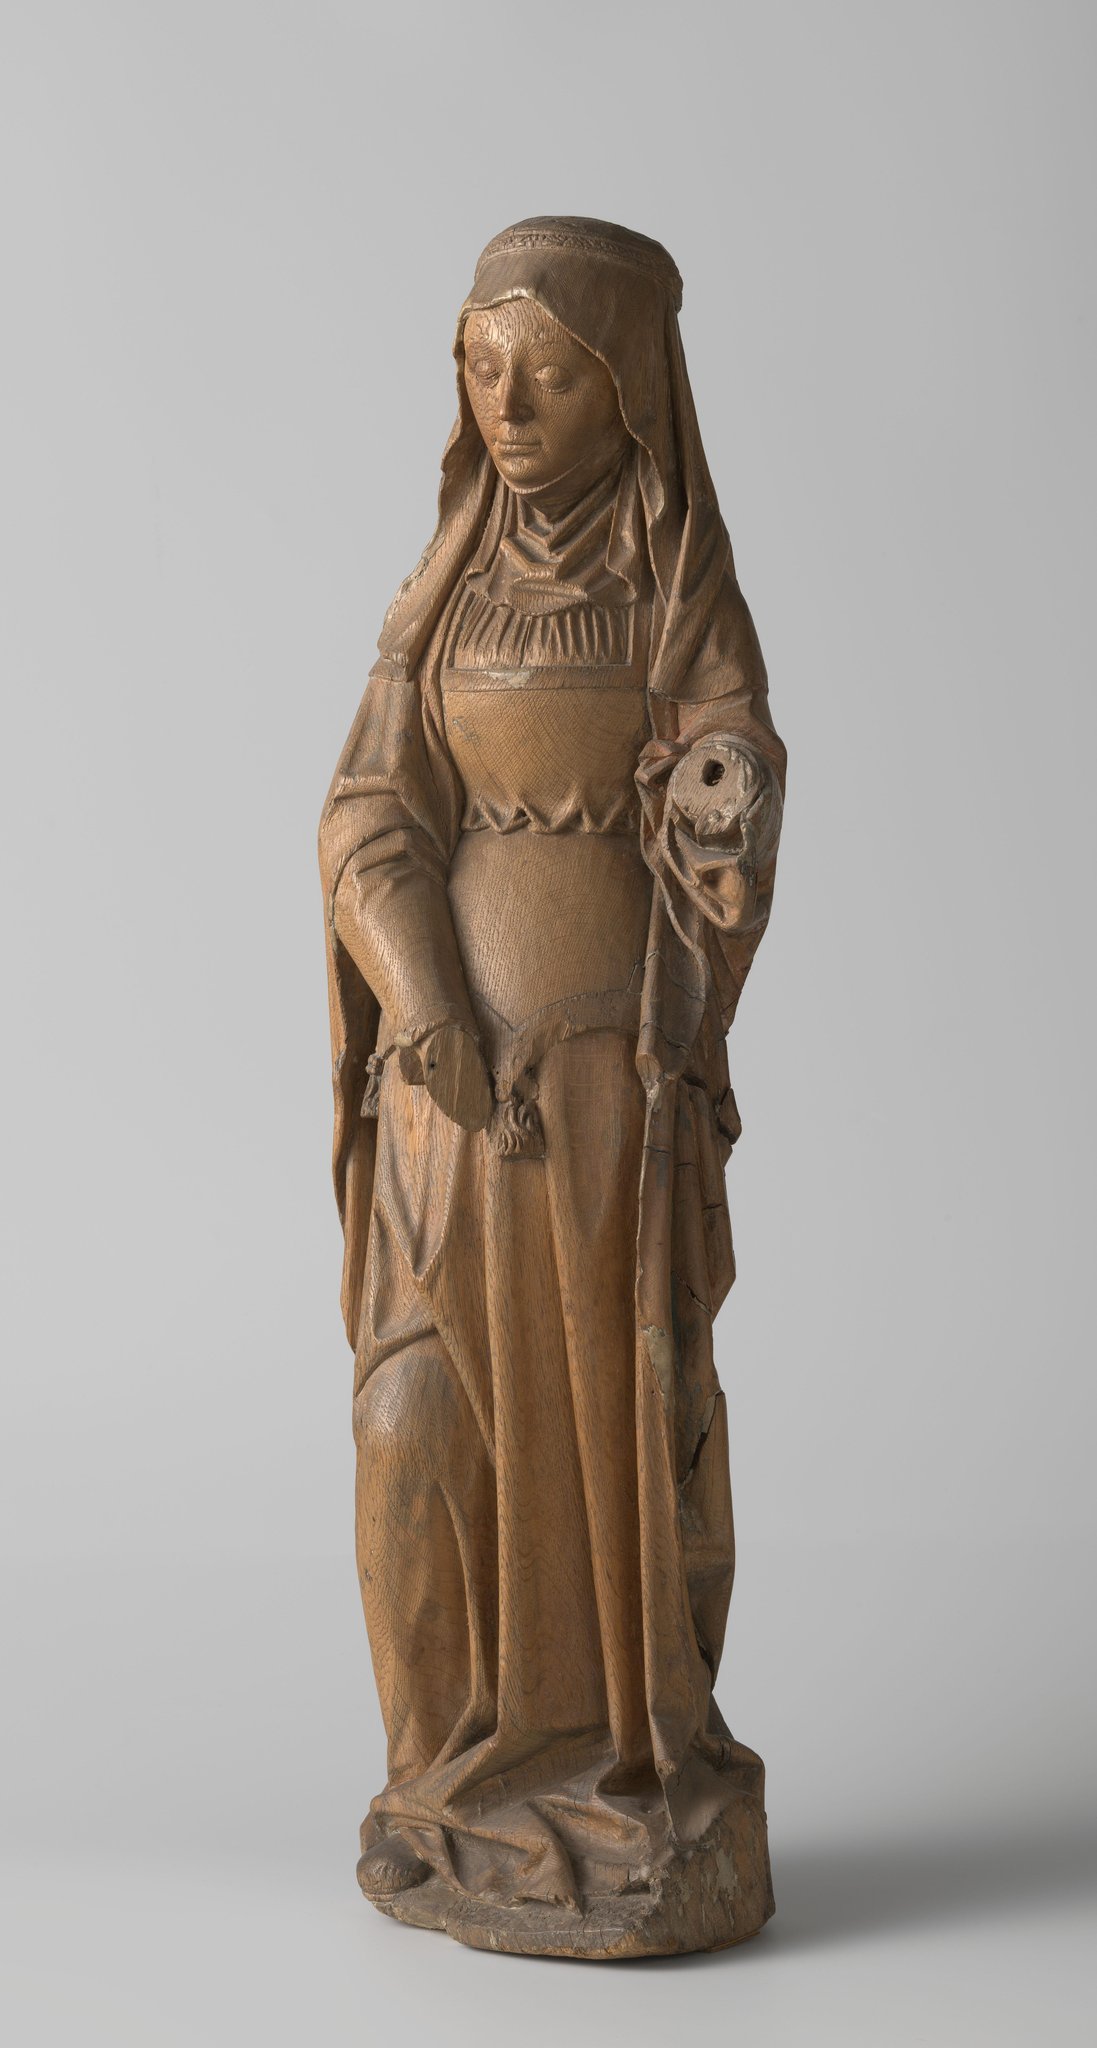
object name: sculpture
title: St Anne from of a Virgin and Child with St Anne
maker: Anonymous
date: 1510-1520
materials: wood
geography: north brabant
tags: 'anna selbdritt', i.e. anna, mary and christ-child close together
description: Zij staat met het rechterbeen naar voren; de rechterarm hangt naar beneden, haar blik gaat schuin omlaag. Onder de van het hoofd afhangende sluier is de kindoek bevestigd, die over het geplooide hemd valt, dat onder de hoekige halsuitsnijding van het keurslijf uitkomt. Het laatste is om het middel gegord en onderaan geschulpt en van kwasten voorzien. Van de schoudes hangt de mantel, die bij de linker elleboog is opgenomen. De rok laat de stompe schoenpunt vrij.